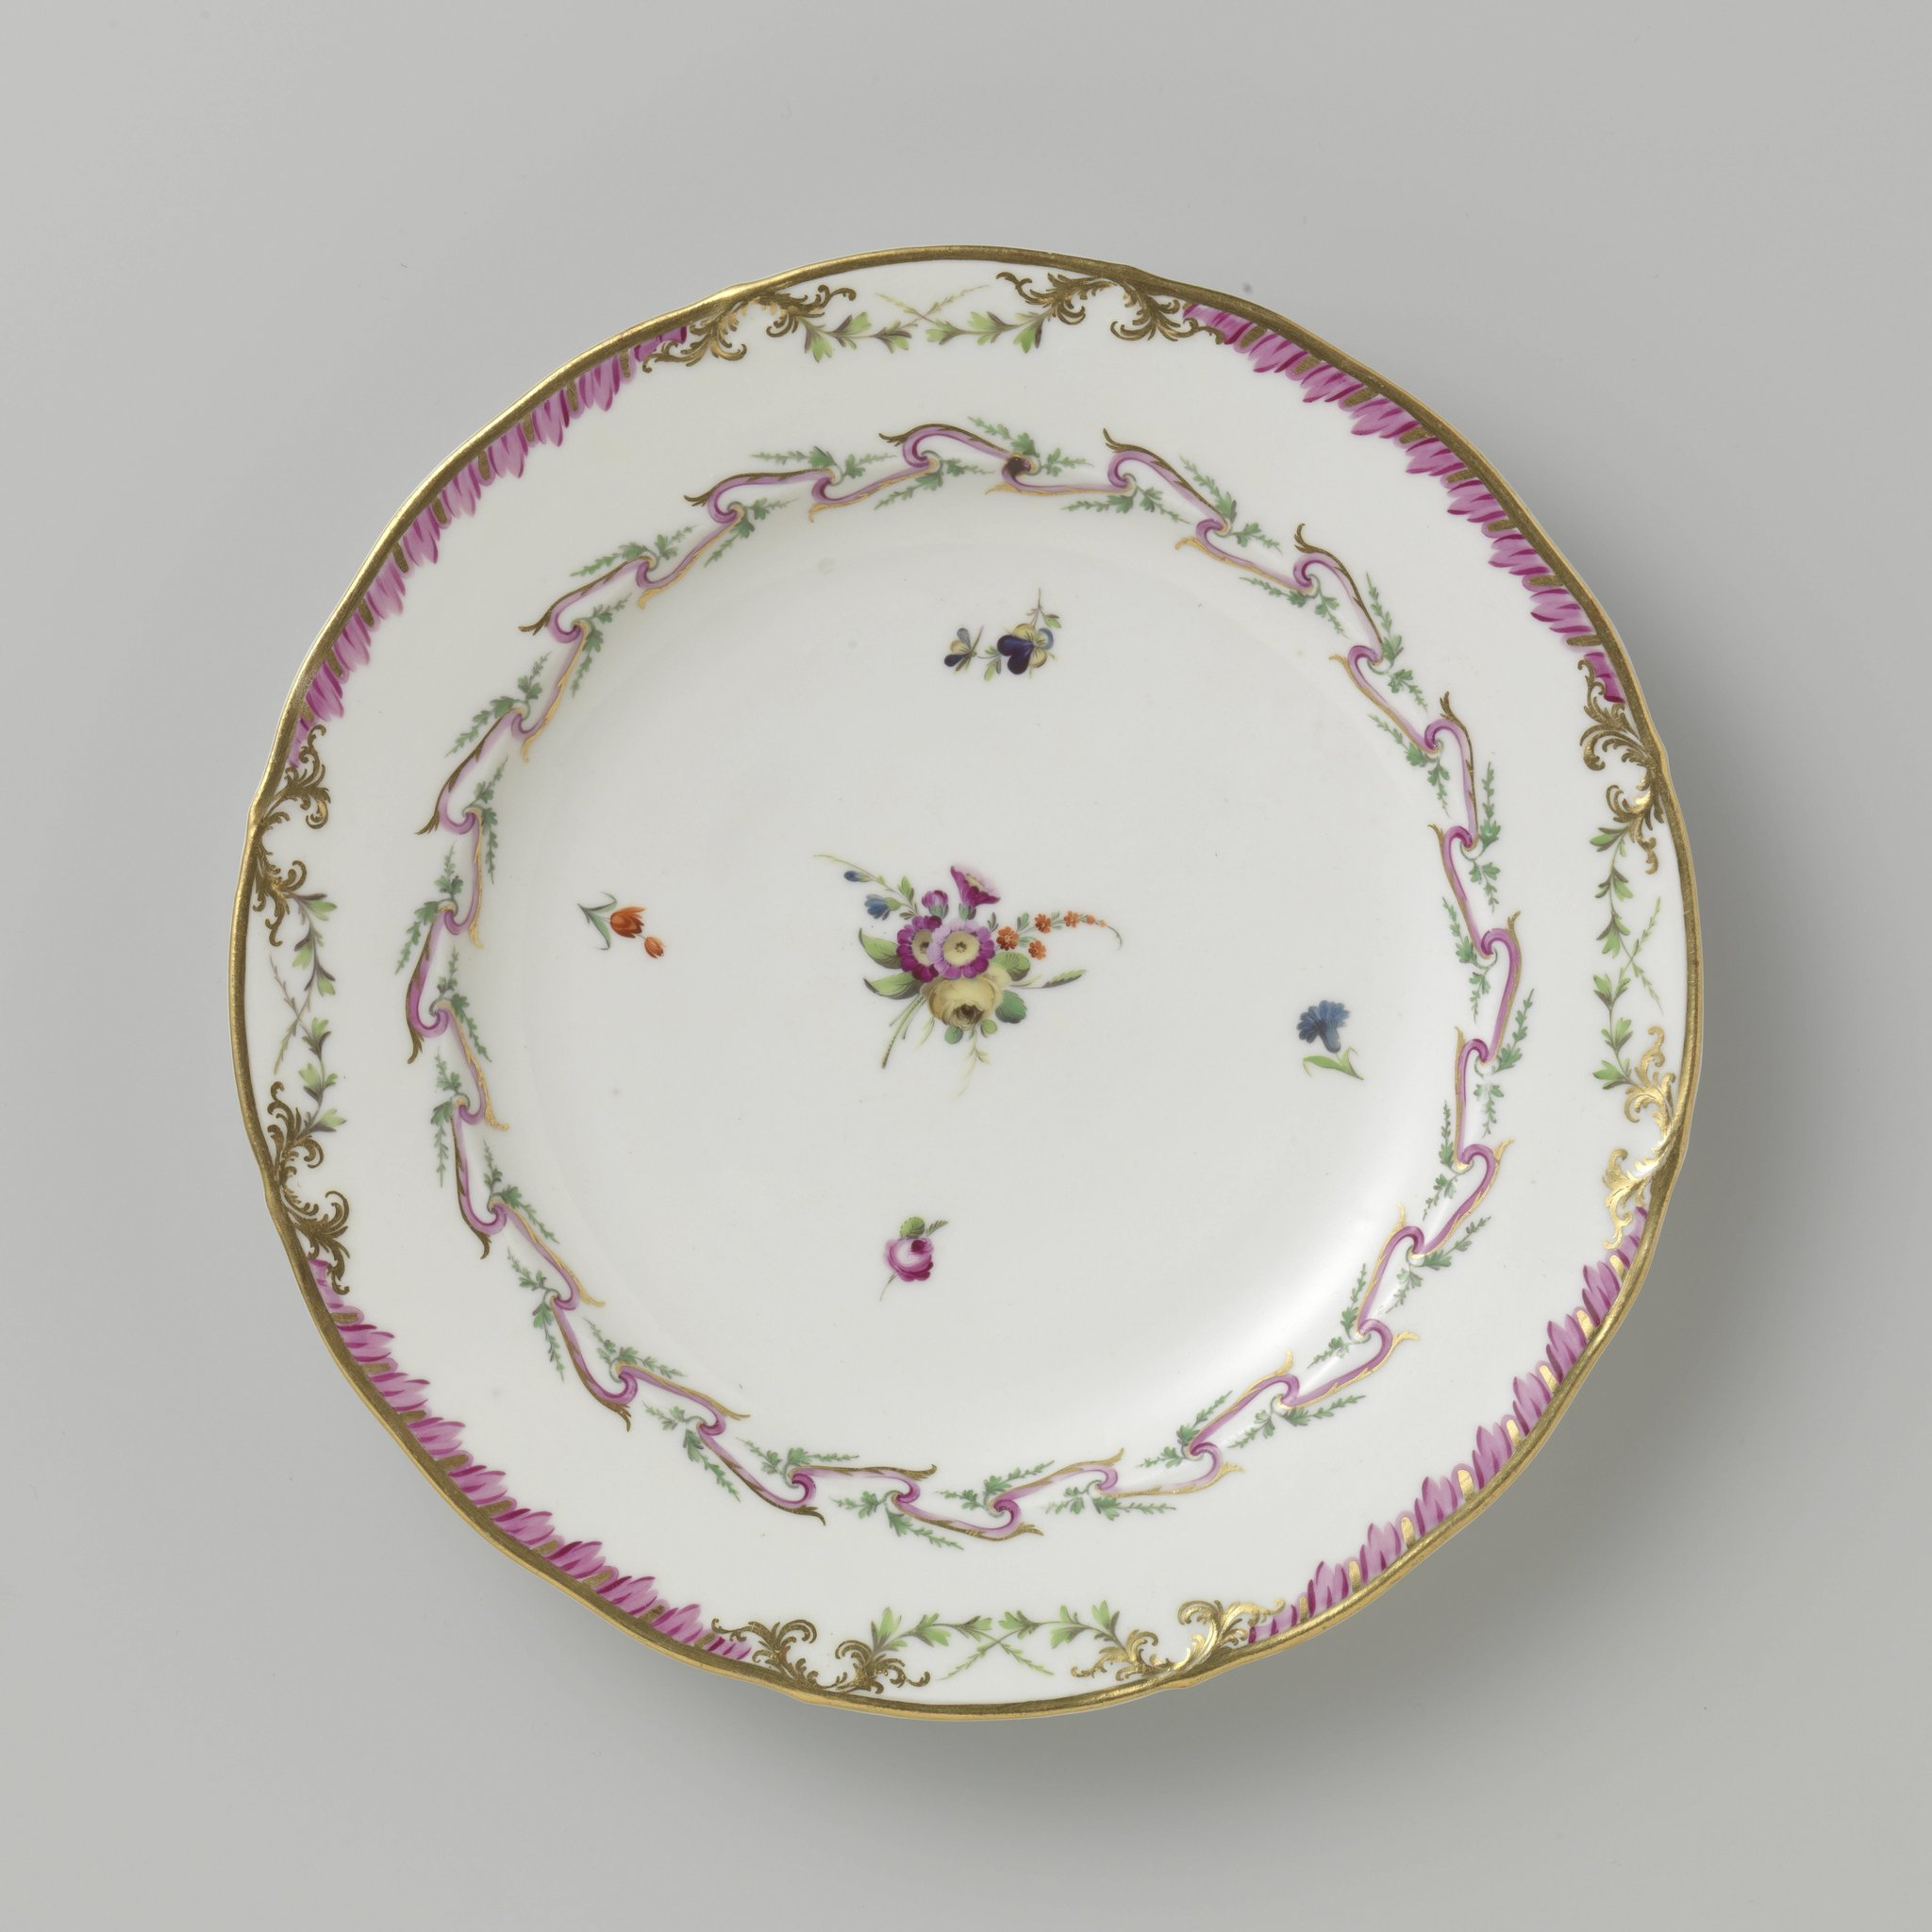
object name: plate dish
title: Bord, plat model, behorend bij een servies met geslingerd lintmotief met bladertakken, bloemboeketten en gestrooide bloemtakken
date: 1780-1820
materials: porcelain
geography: amsterdam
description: Bord, plat model, behorend bij een servies van porselein met geslingerd lintmotief in paars en goud met groene bladertakken, bloemboeketten en gestrooide bloemtakken. Randen lichtgegolfd met decoratie in goud met paars bladmotief waartussen groen gekruist bladmotief. Gemerkt: M.O.L. of AMSTEL.